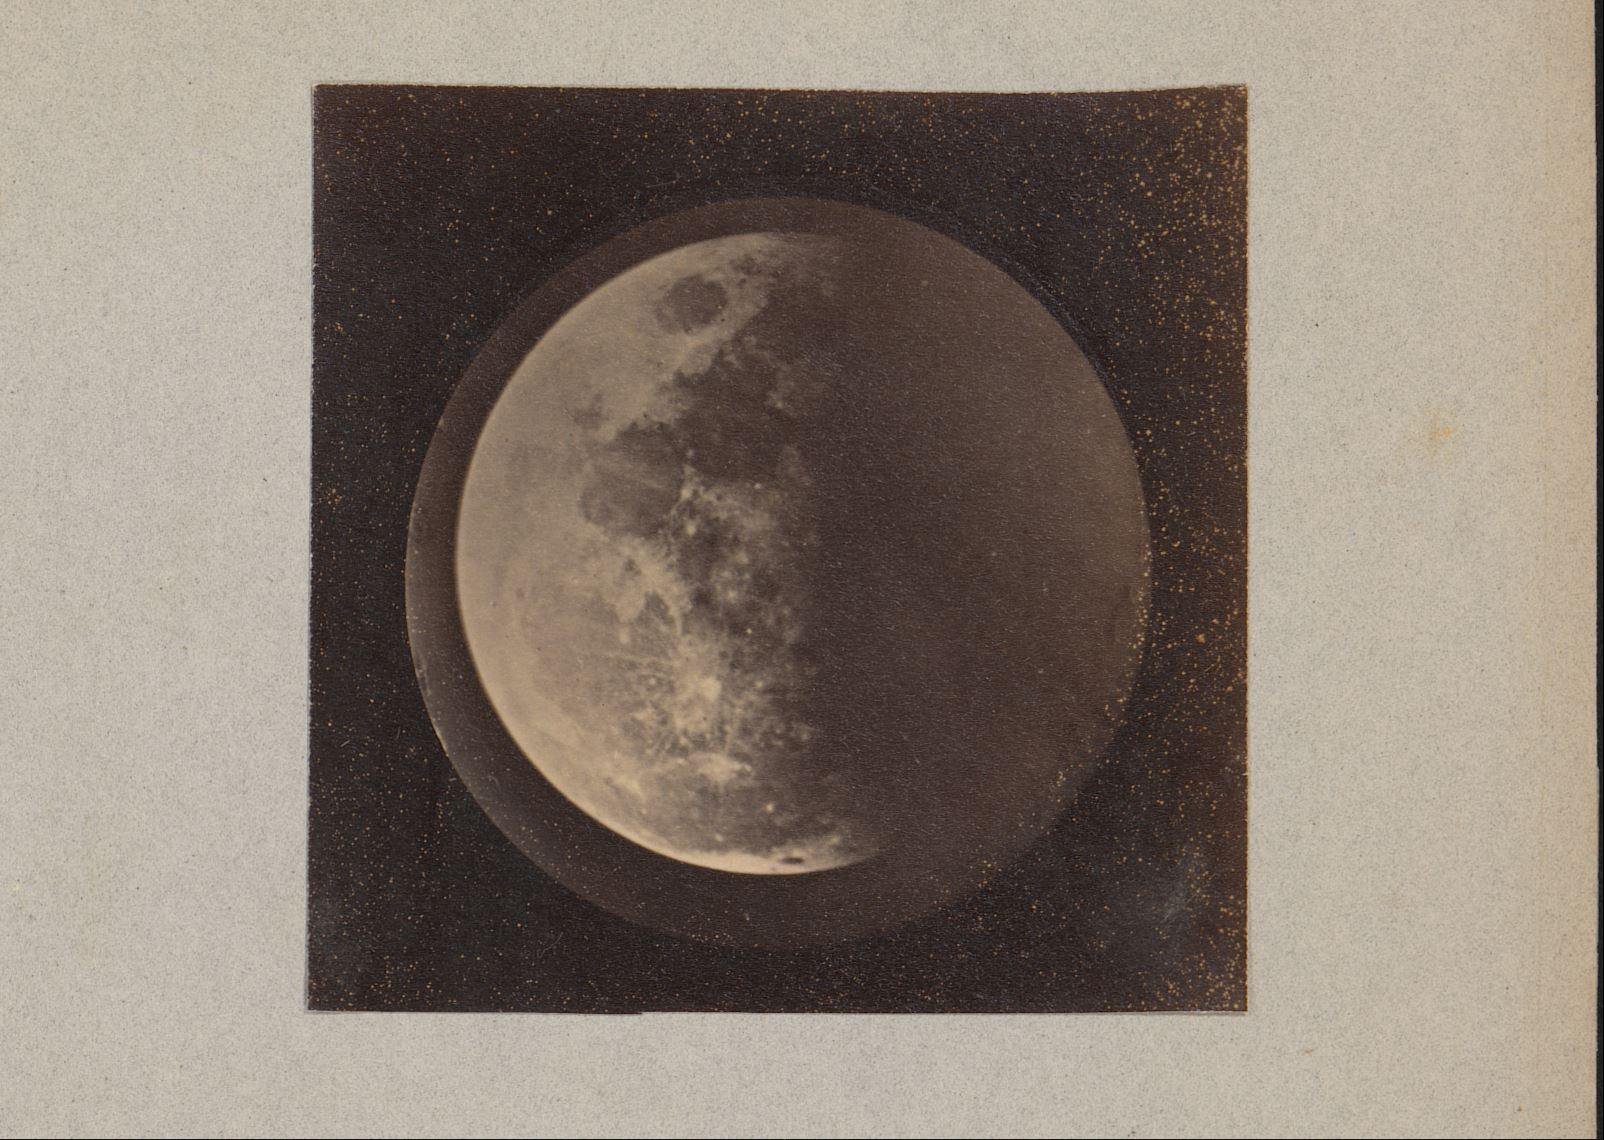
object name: photograph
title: Fotoreproductie van foto door Warren de la Rue van vlekken op de maan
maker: marinus pieter filbri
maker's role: instrument maker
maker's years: 1852-1917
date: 1887-1888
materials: paper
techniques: albumen print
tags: surface of the moon, moon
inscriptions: inscription: ‘Vlekken op de maan/ naar phot.’